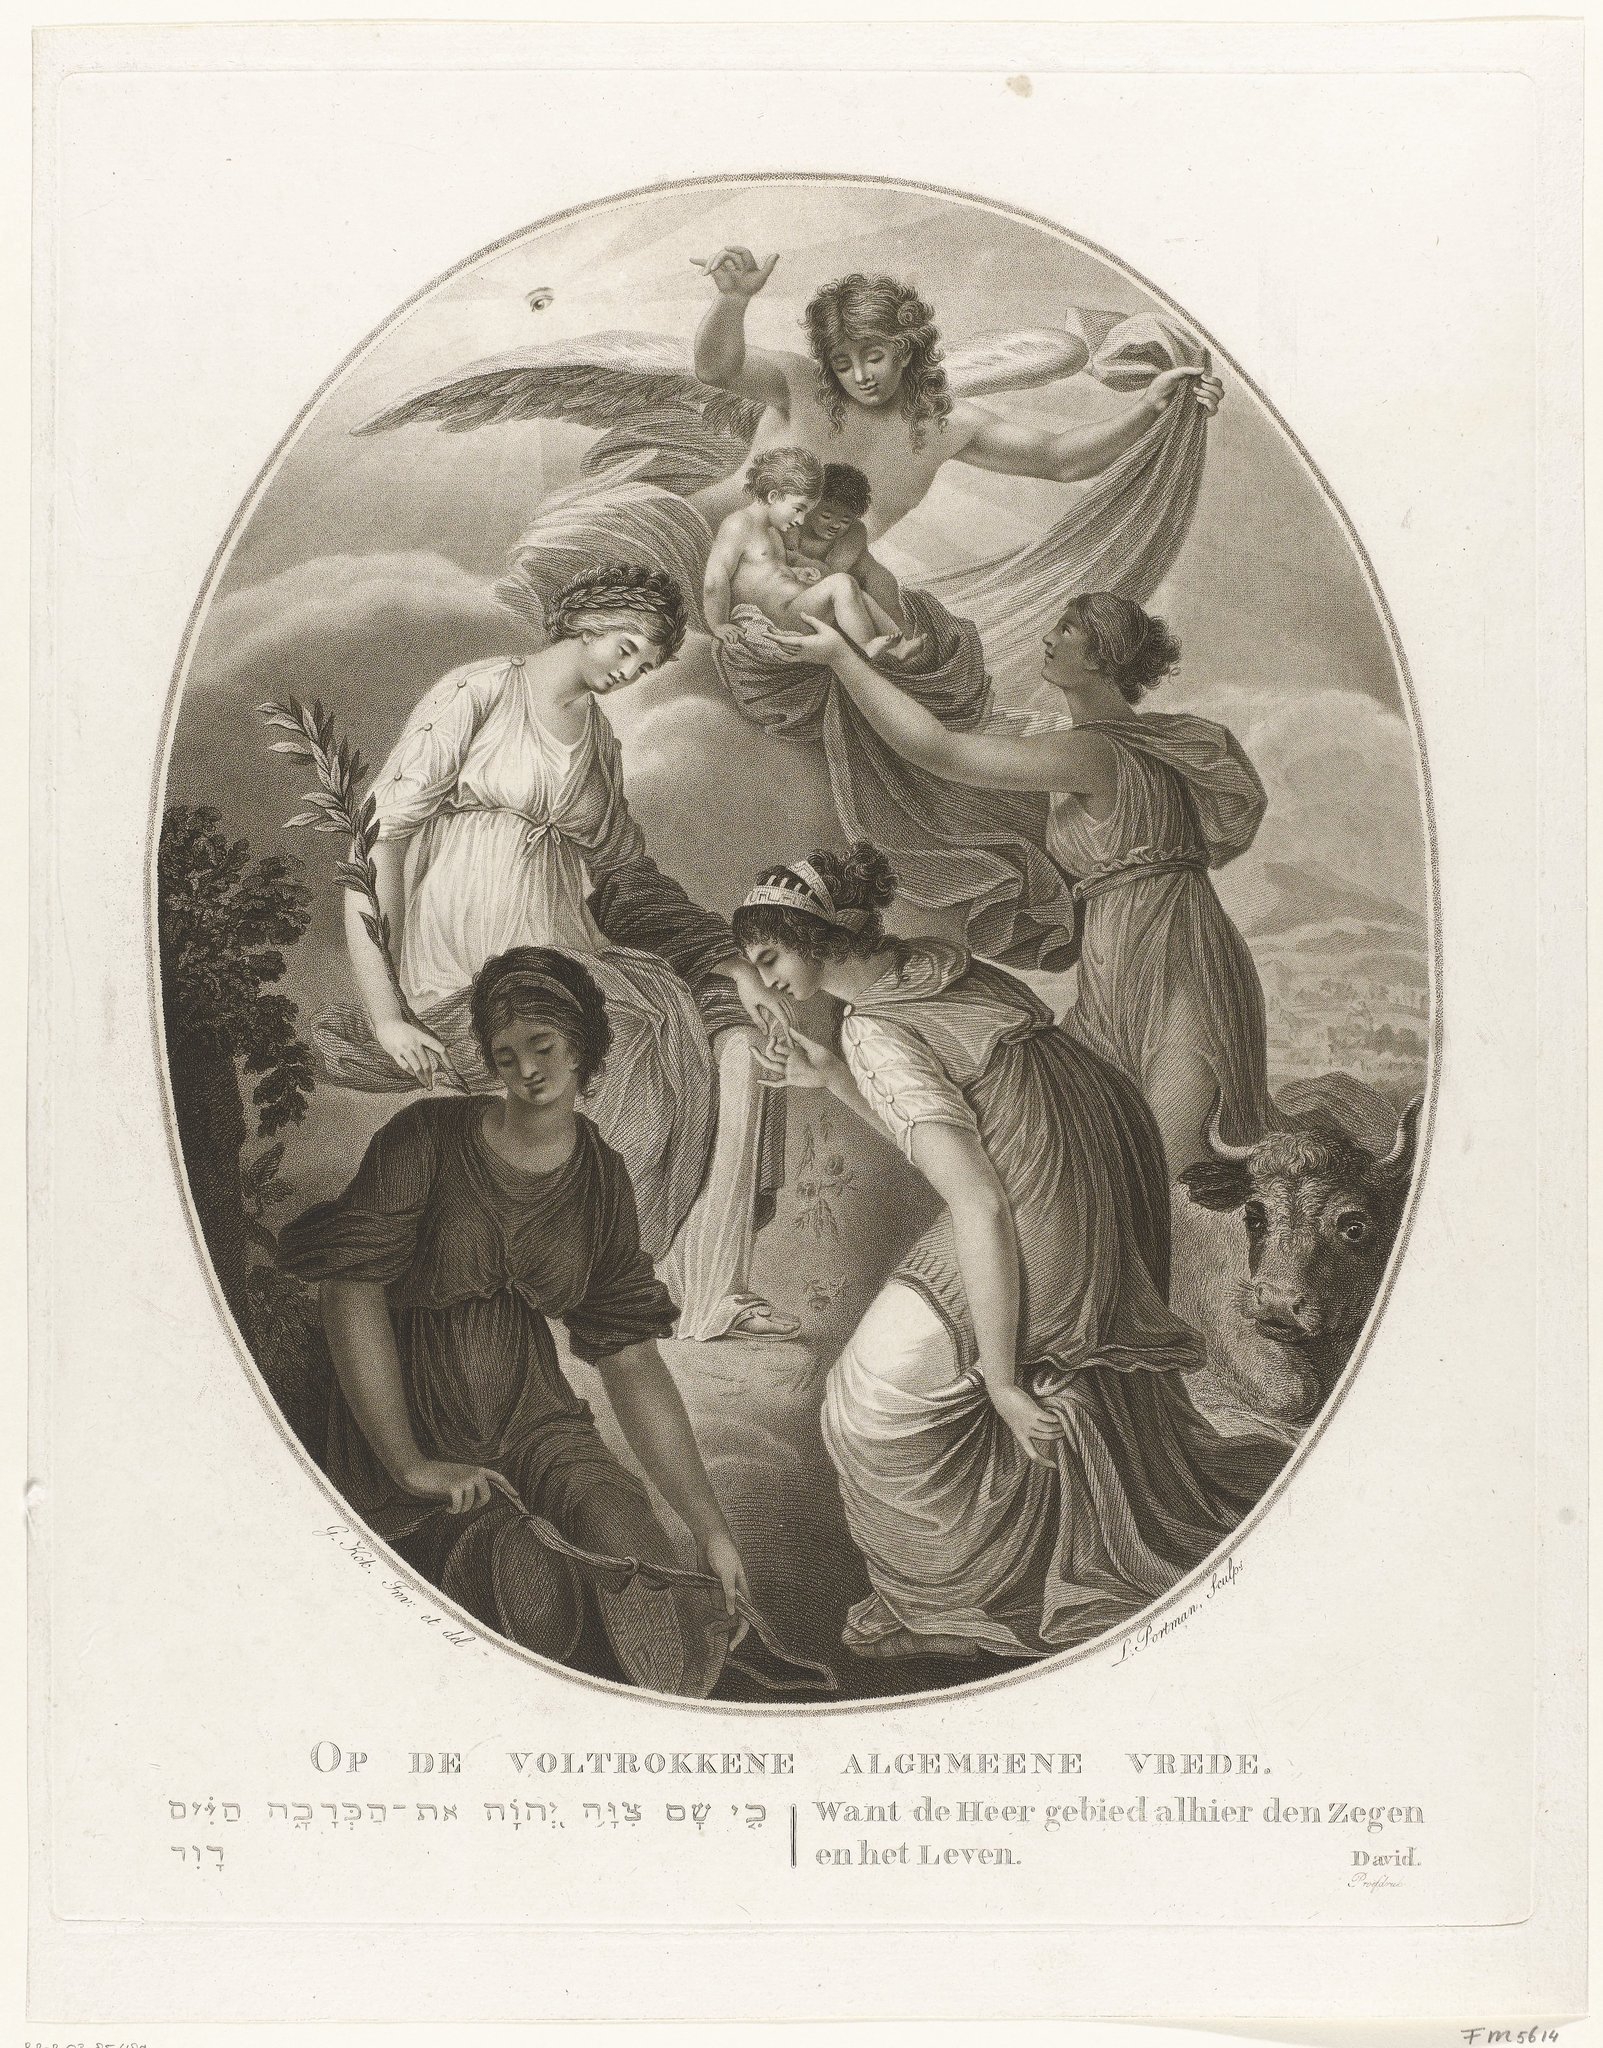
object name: print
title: Allegorie op de vrede van Amiens, 1797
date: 1802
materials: paper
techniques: engraving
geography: netherlands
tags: europe represented allegorically; 'europa' (ripa), symbols, allegories of peace, 'pax'; 'pace' (ripa), europa and her maidens play with the bull, and/or adorn it with flowers, great britain, france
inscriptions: collector's mark: Lugt 2228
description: Allegorie op de vrede van Amiens tussen Frankrijk en Groot-Brittannië, 27 maart 1802. Ovale voorstelling waarin de Een vrouw de hand kust van de zittende Vrede. Op de voorgrond worden wapenschilden bijeen gebonden. Op de achtergrond Europa (met stier) met twee geniussen en een engel. Onderaan de titel en een bijbeltekst in het Hebreeuws en Nederlands.